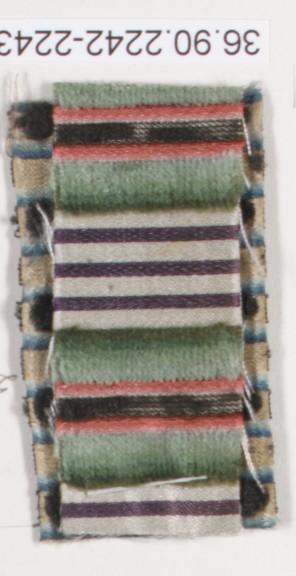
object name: piece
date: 1801-1900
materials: silk